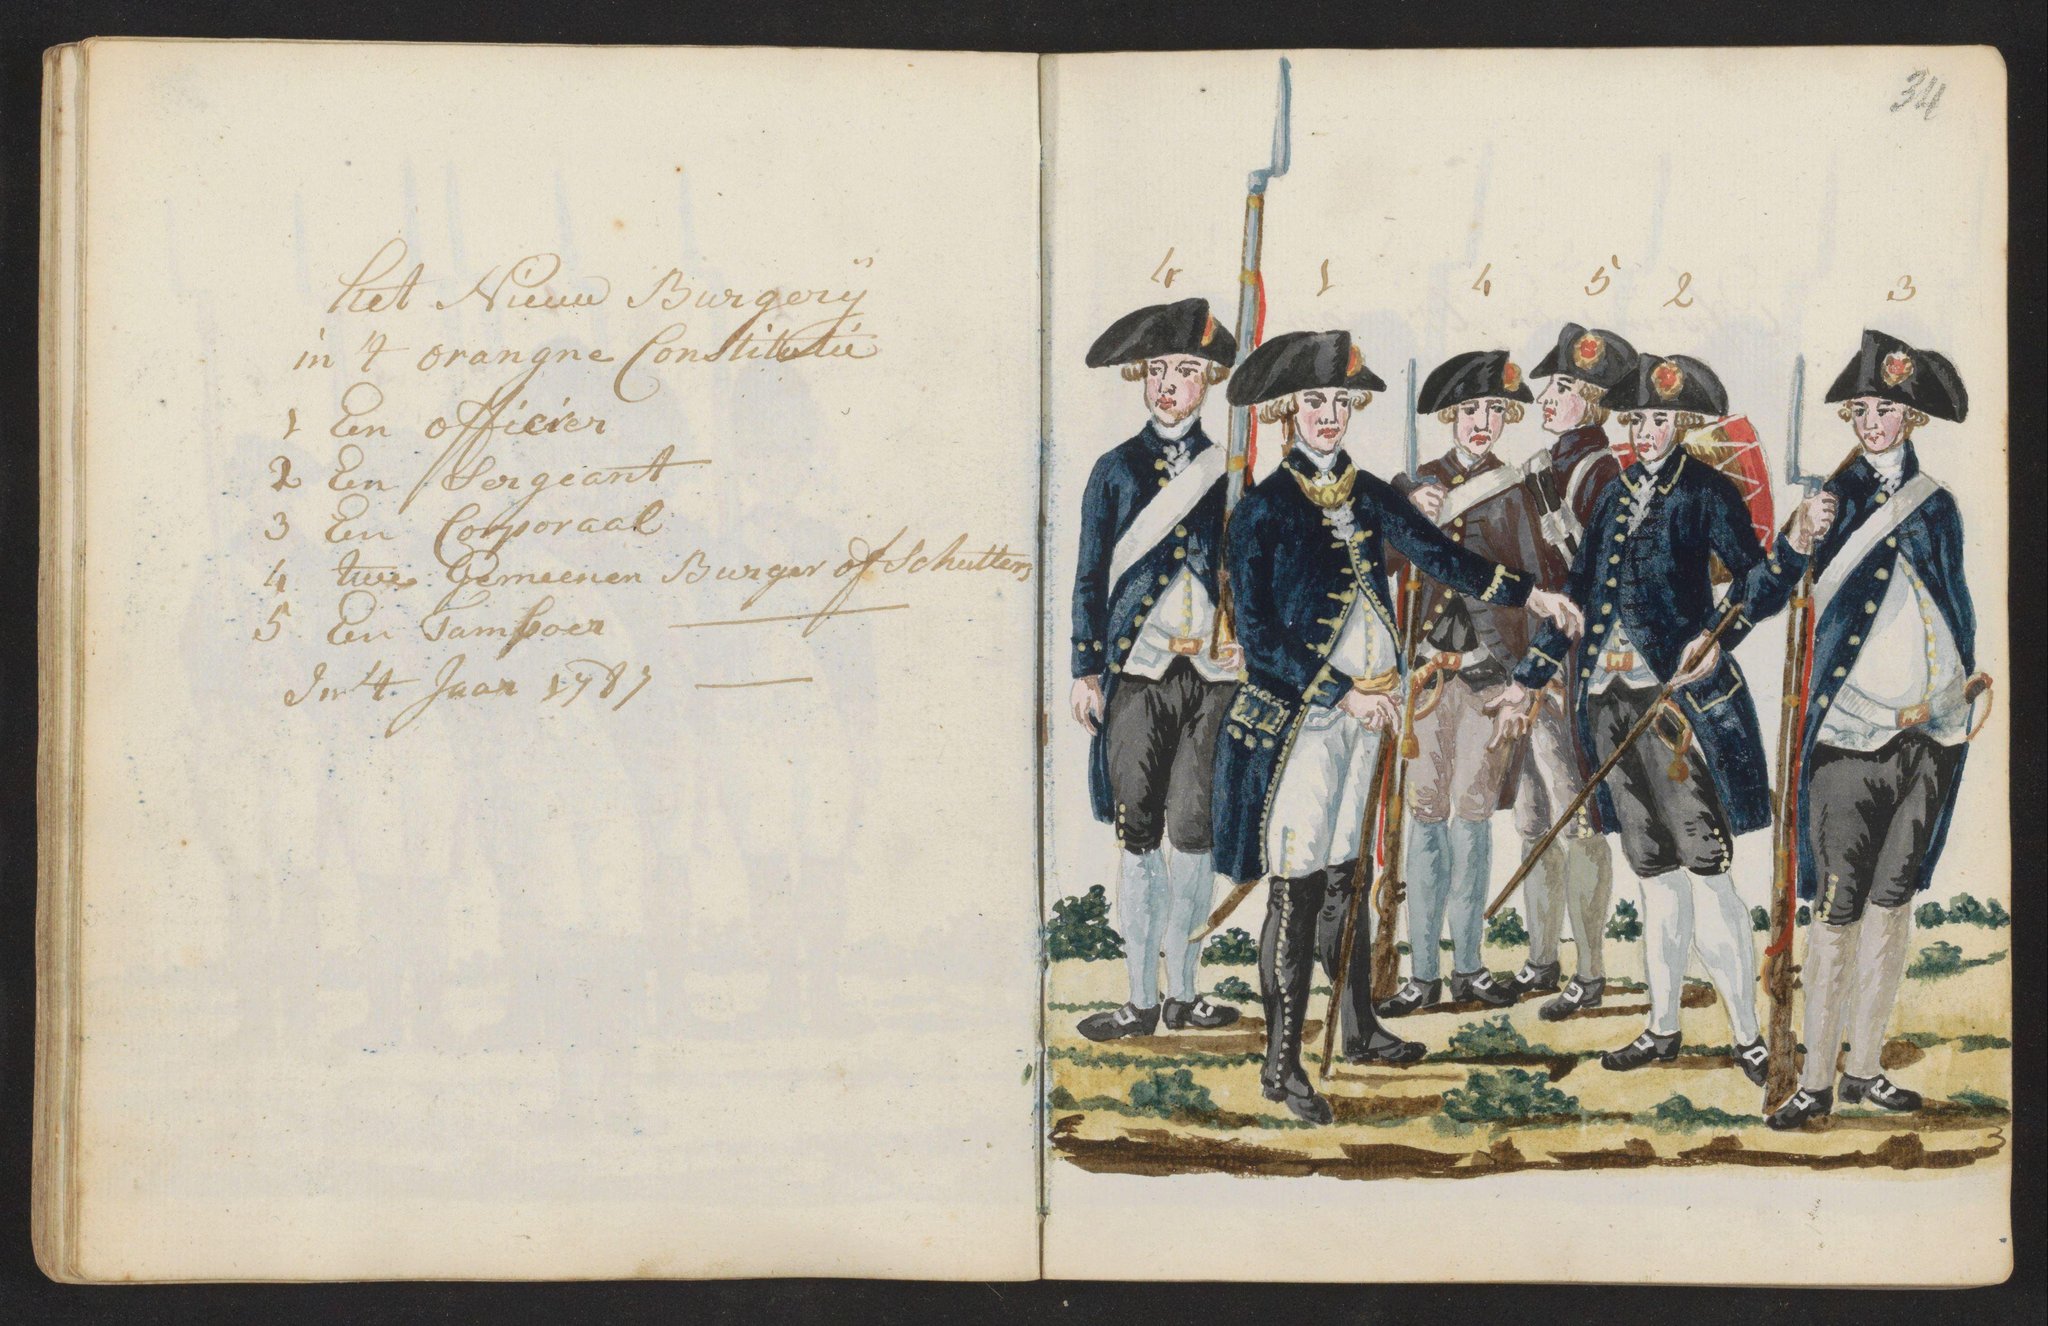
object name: drawing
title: Uniformen van de nieuwe Amsterdamse schutterij in 1787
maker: s.g. casten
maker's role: draughtsman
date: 1795-1796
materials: paper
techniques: writing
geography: amsterdam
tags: (military) uniforms (+ citizen soldiery, civil guard, citizen militia), amsterdam, patriots (1780-1795)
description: Vijf uniformen van de nieuwe Amsterdamse schutterij in 1787: officier, sergeant, corporaal, gewone burger of schutter en een tamboer. Onderdeel van het derde hoofdstuk over de nieuwe uniformen in de periode na het herstel van de prins van Oranje en de komst van de Pruisische troepen in Holland in 1787. In het schetsboek met gekleurde tekeningen van de uniformen van militairen en leden van de schutterij uit de periode 1770 tot 1795-1796.